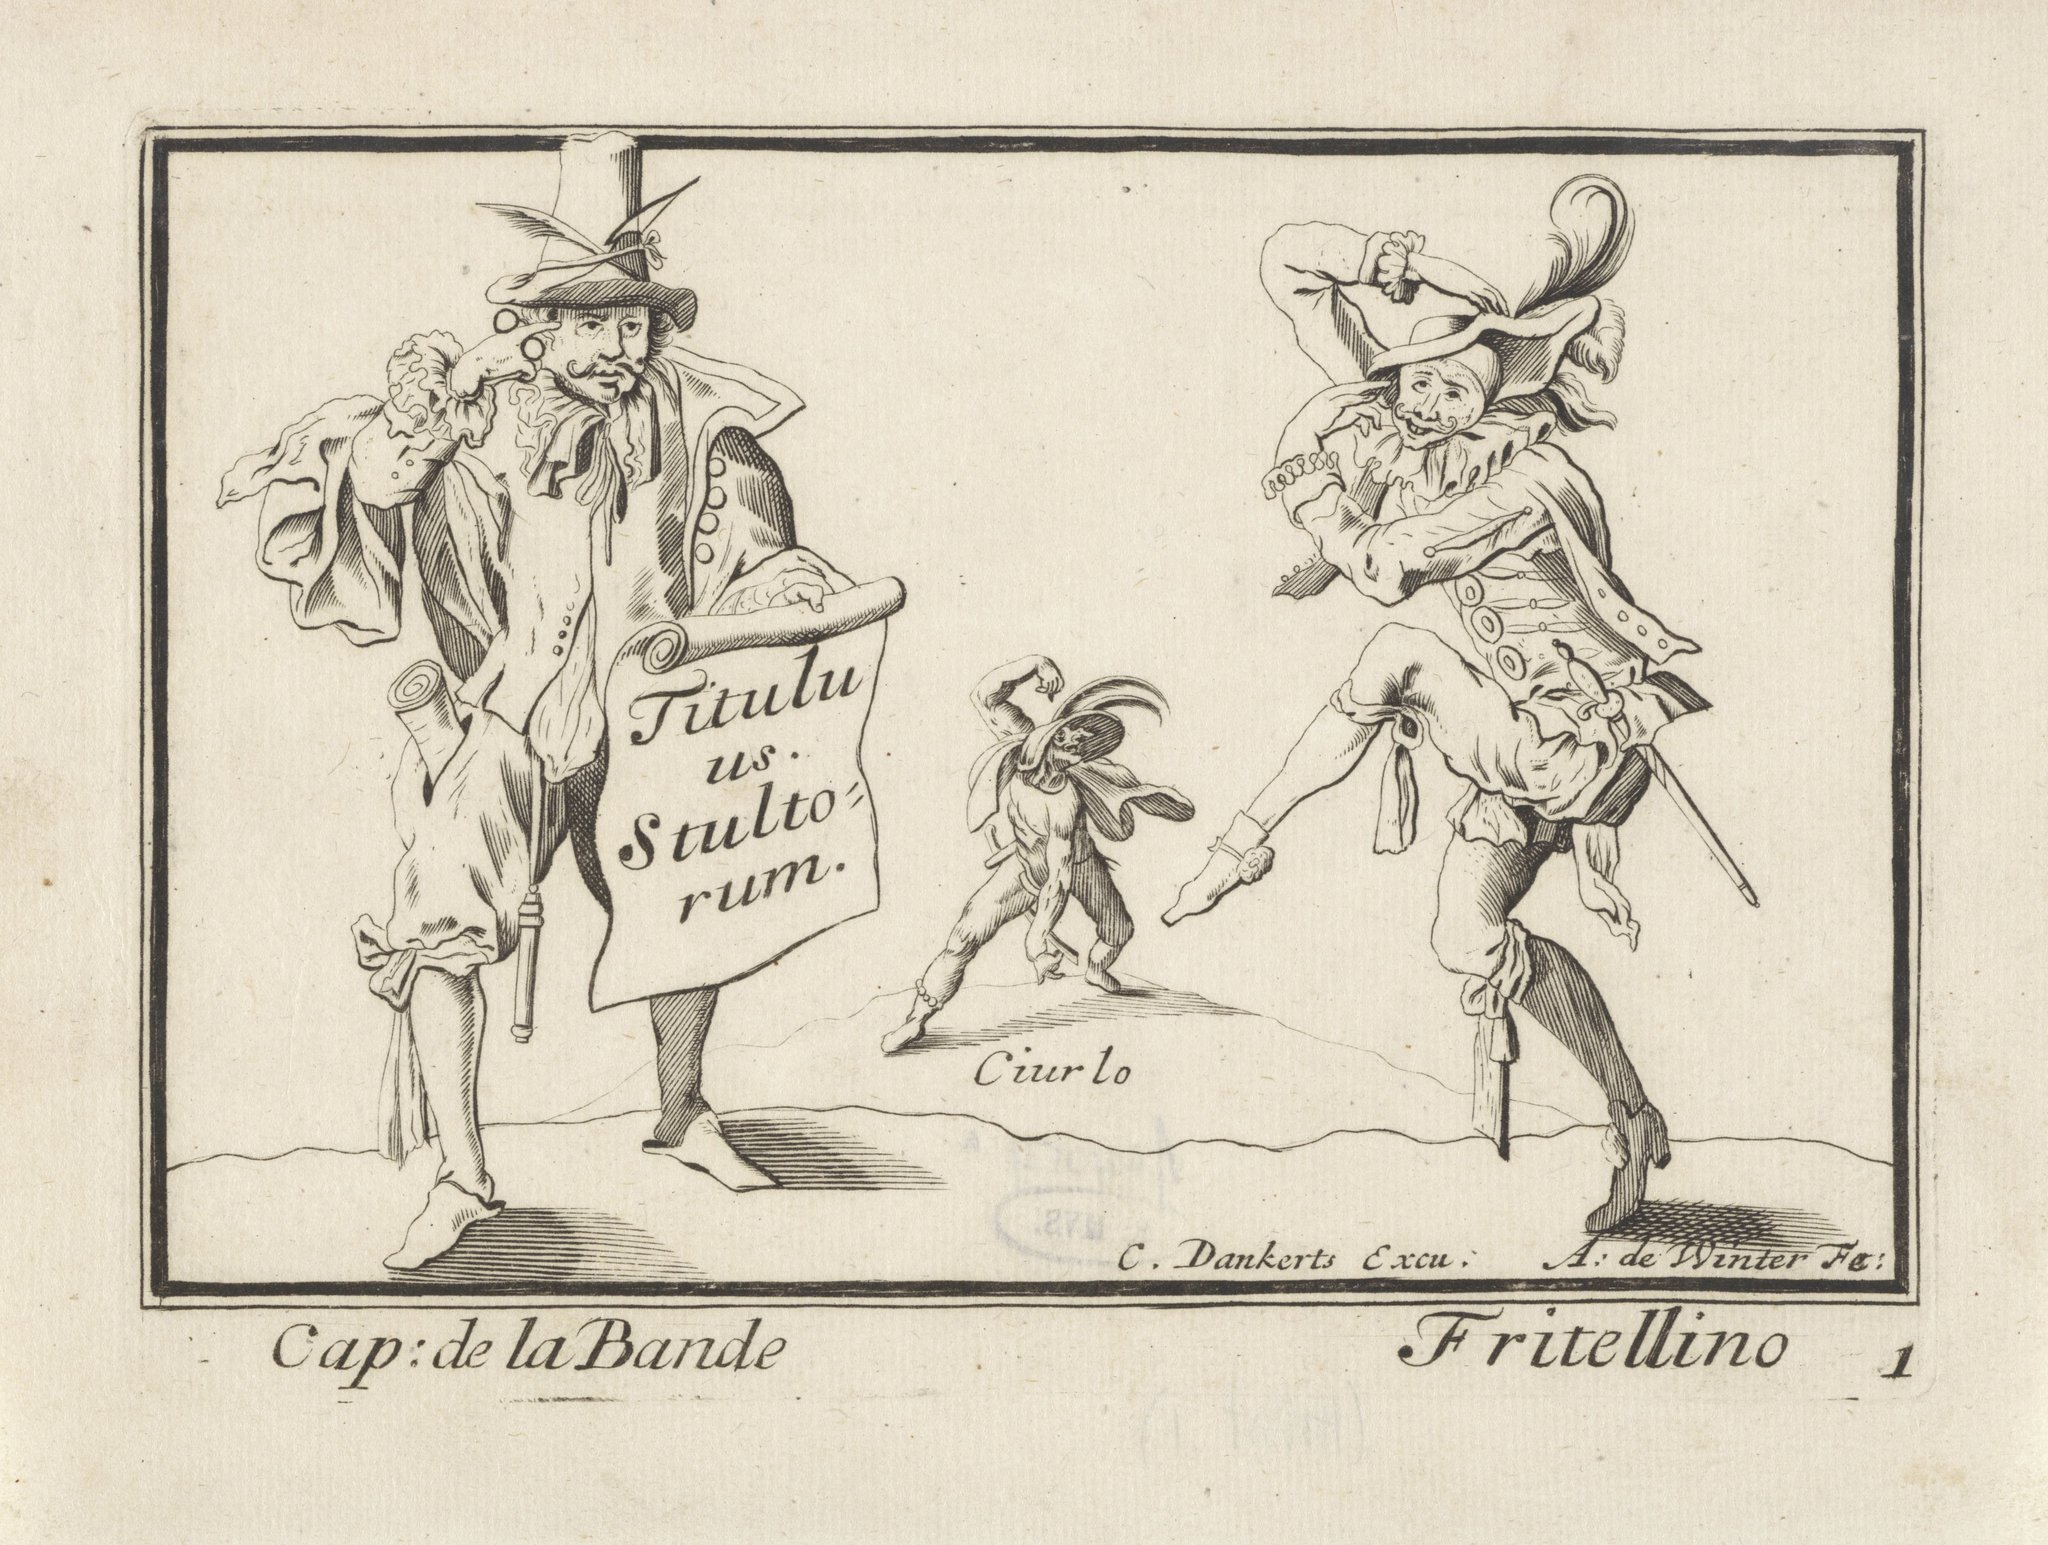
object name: titelprent, frontispice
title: Cap. de la Bande, Ciurlo en Fritellino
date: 1668-1707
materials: paper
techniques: etching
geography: northern netherlands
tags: types in 'commedia dell'arte'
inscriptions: collector's mark: Lugt 2228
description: Drie personages uit de commedia dell'arte. Links Cap. de la Bande met een pince-nez en een boekrol zijn handen. In het midden Ciurlo en rechts een dansende Fritellino.